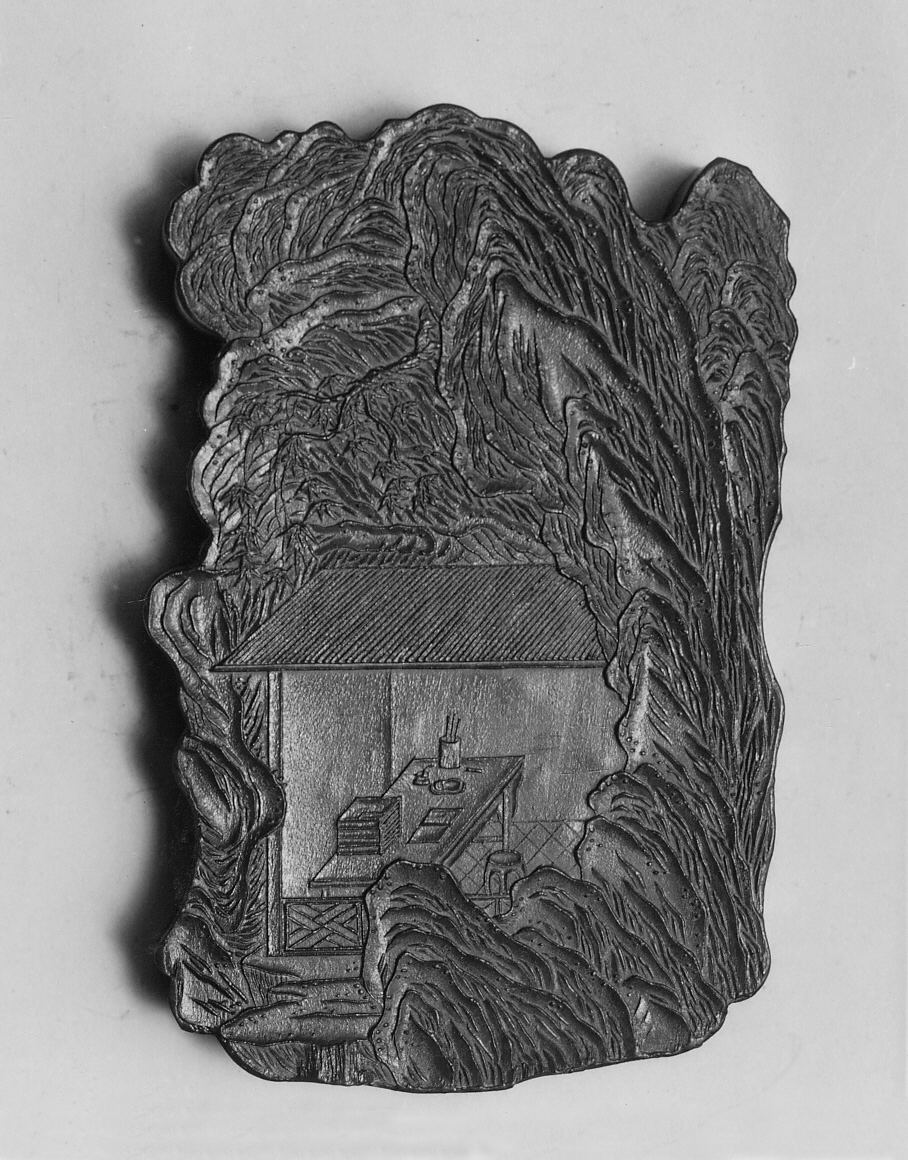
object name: ink tablet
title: The Stone Chamber Where One Writes Exquisite Things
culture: chinese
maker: jian guzhai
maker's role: artist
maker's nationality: chinese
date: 1867-1933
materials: gilt, wood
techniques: bookbinding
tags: pavilions